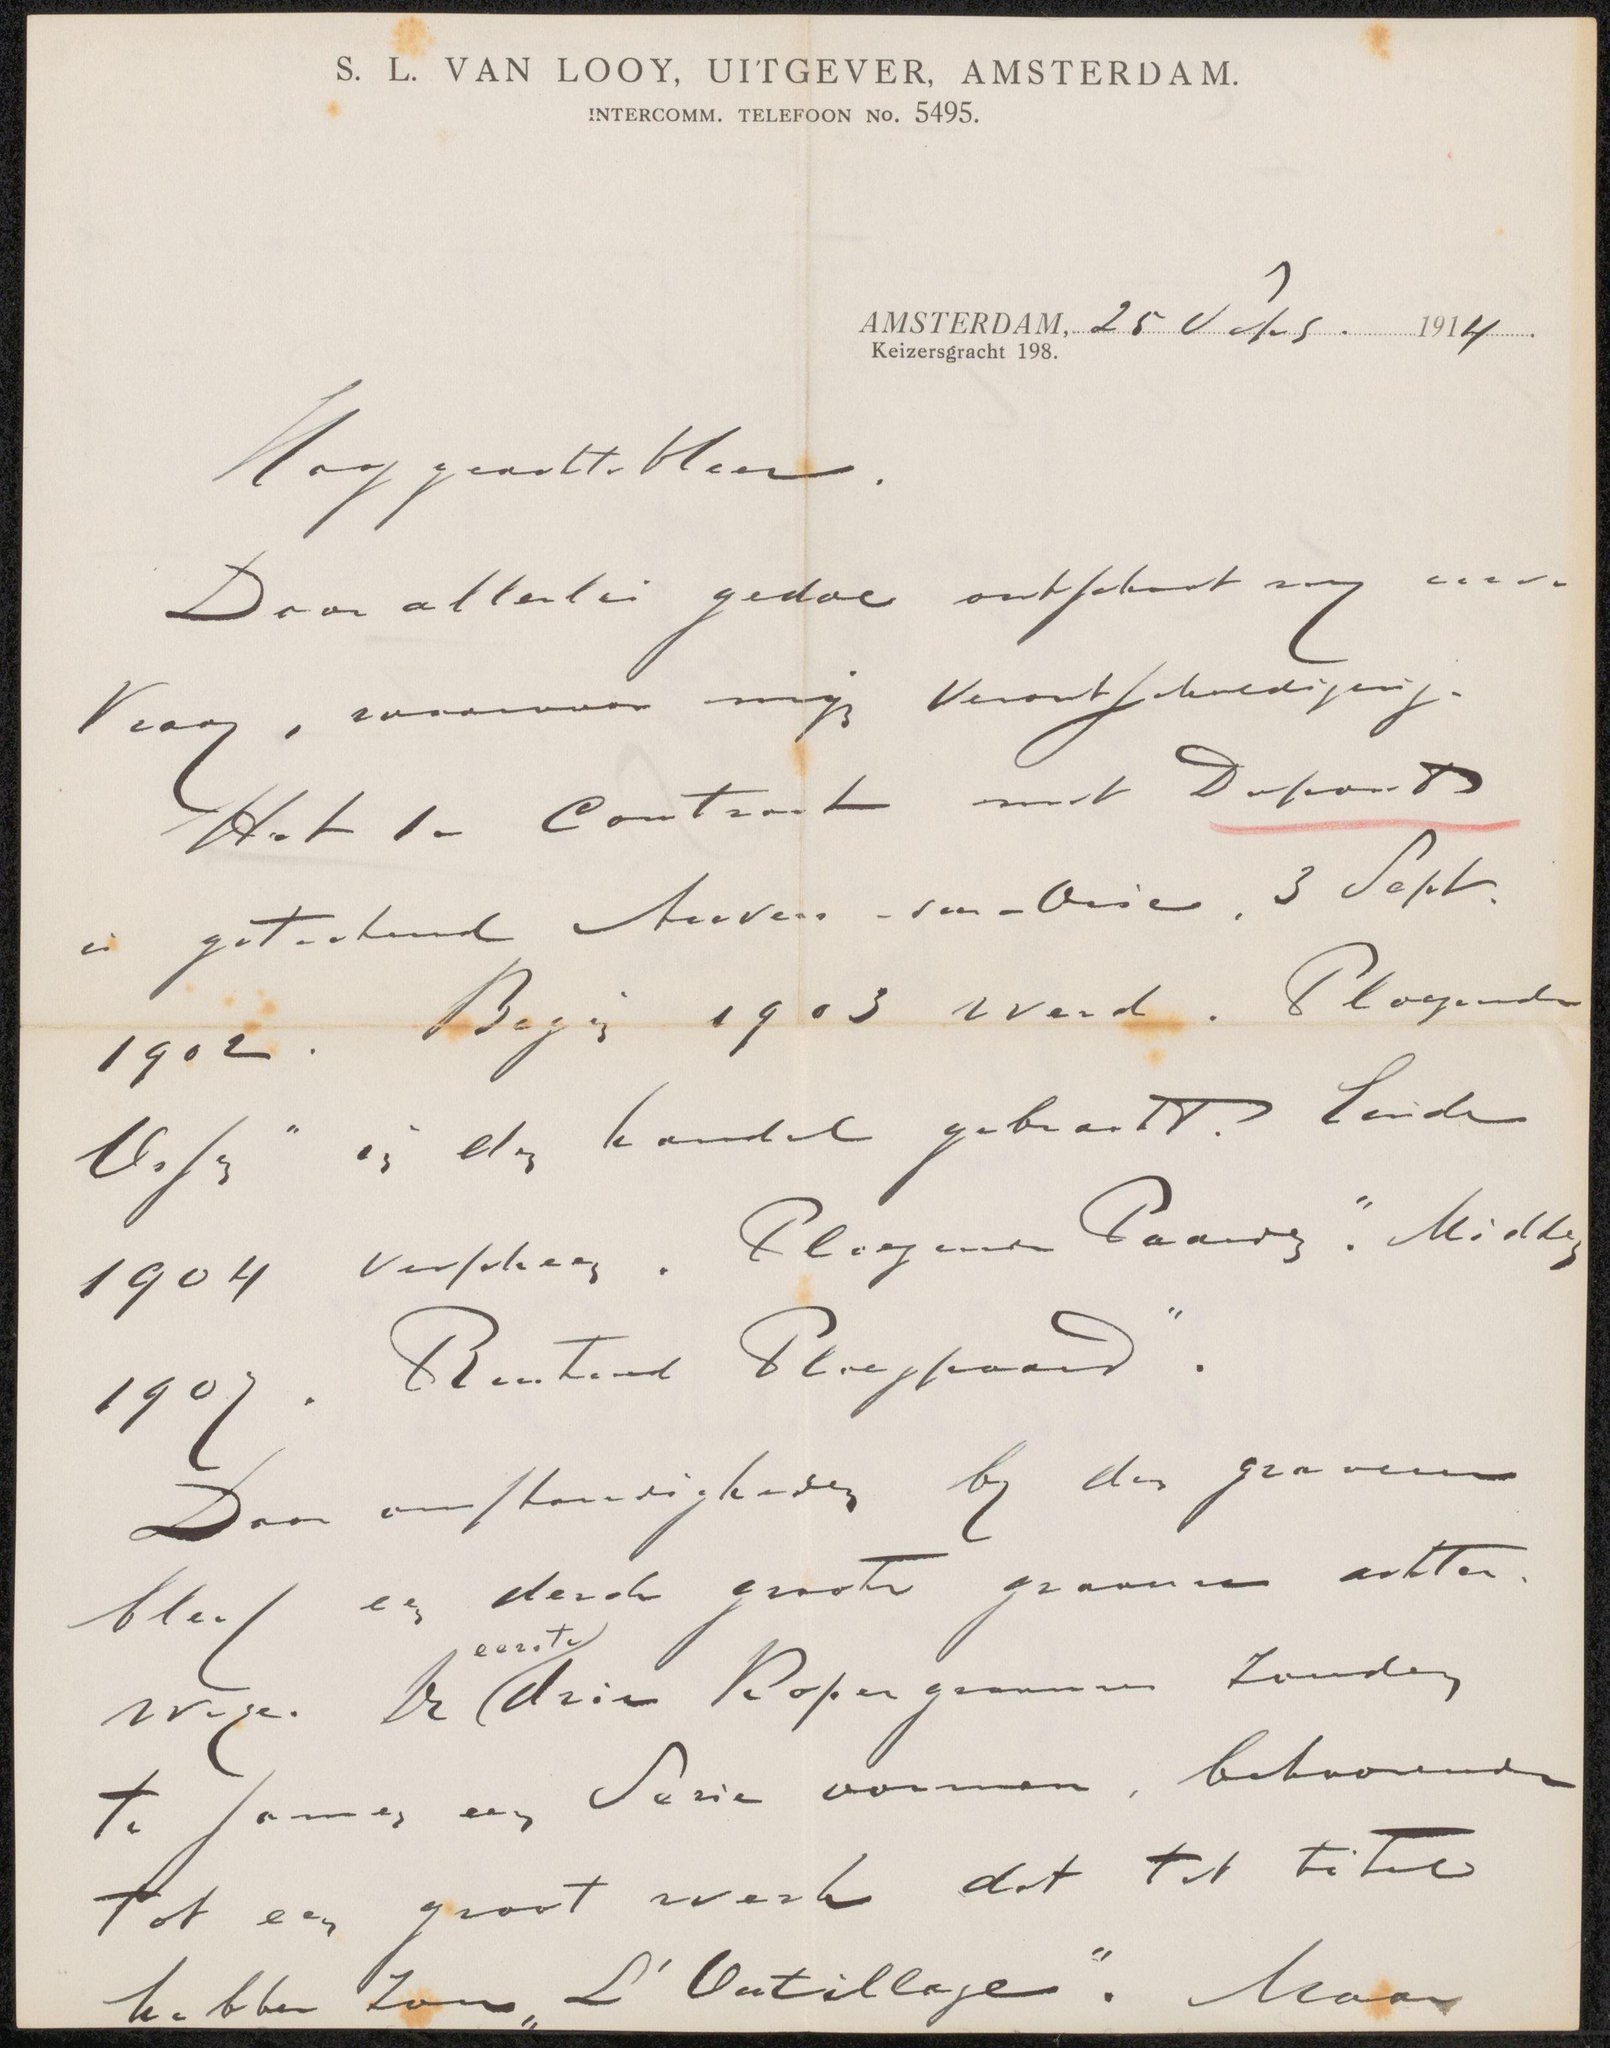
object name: letter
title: Brief aan anoniem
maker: s.l. van looy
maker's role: publisher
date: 1914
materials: ink, paper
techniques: pen, printing, writing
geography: amsterdam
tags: print maker, draughtsman, pieter dupont, art trade, art shop, the graphic arts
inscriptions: watermark, collector's mark: ‘RPK’